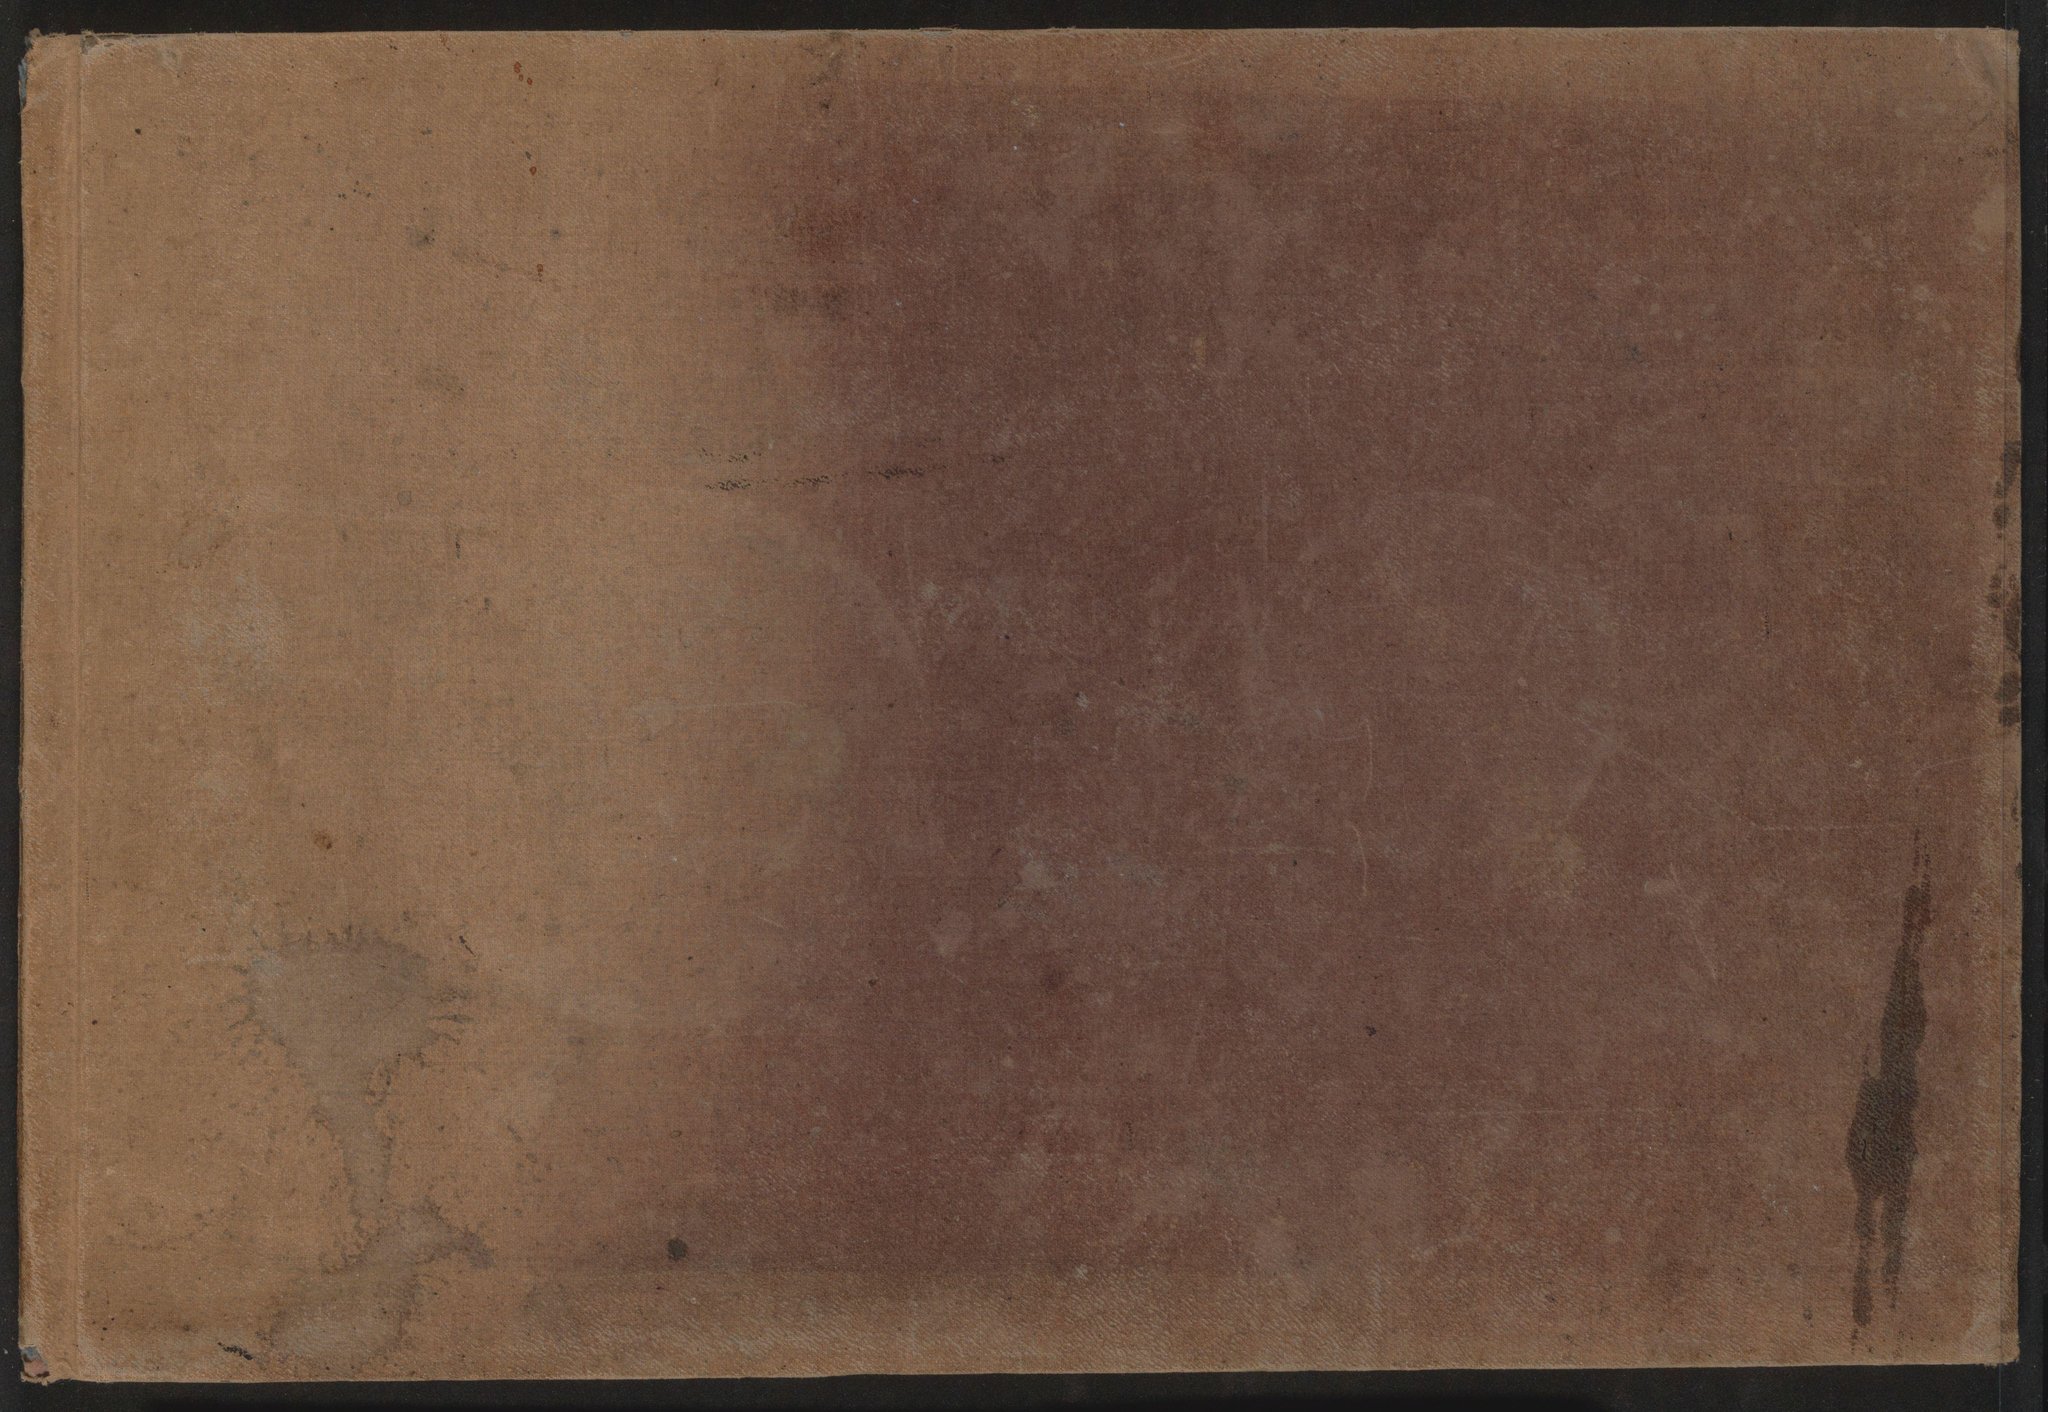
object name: sketchbook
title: Schetsboek met 23 bladen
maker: pierre joseph hubert cuypers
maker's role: draughtsman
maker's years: 1827-1921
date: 1837-1921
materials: cardboard, chalk, ink, linen, paper, pencil, watercolor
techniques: printing, brush, pen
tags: (liturgical) equipment of church, architectural detail, church (exterior), foliage, tendrils, branches ~ ornament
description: De volgende bladen uit het schetsboek zijn blanco: 1(R), 3(V) en 7(V). Tussen de genummerde bladen 7 en 8 zitten twee ongenummerde blanco bladen. Tussen de genummerde bladen 13 en 14 zitten vier ongenummerde blanco bladen en tussen de genummerde bladen 16 en 17 zitten vier ongenummerde blanco bladen. Tussen blad 6 en 7 zit een omslag met drie gedroogde bladeren.